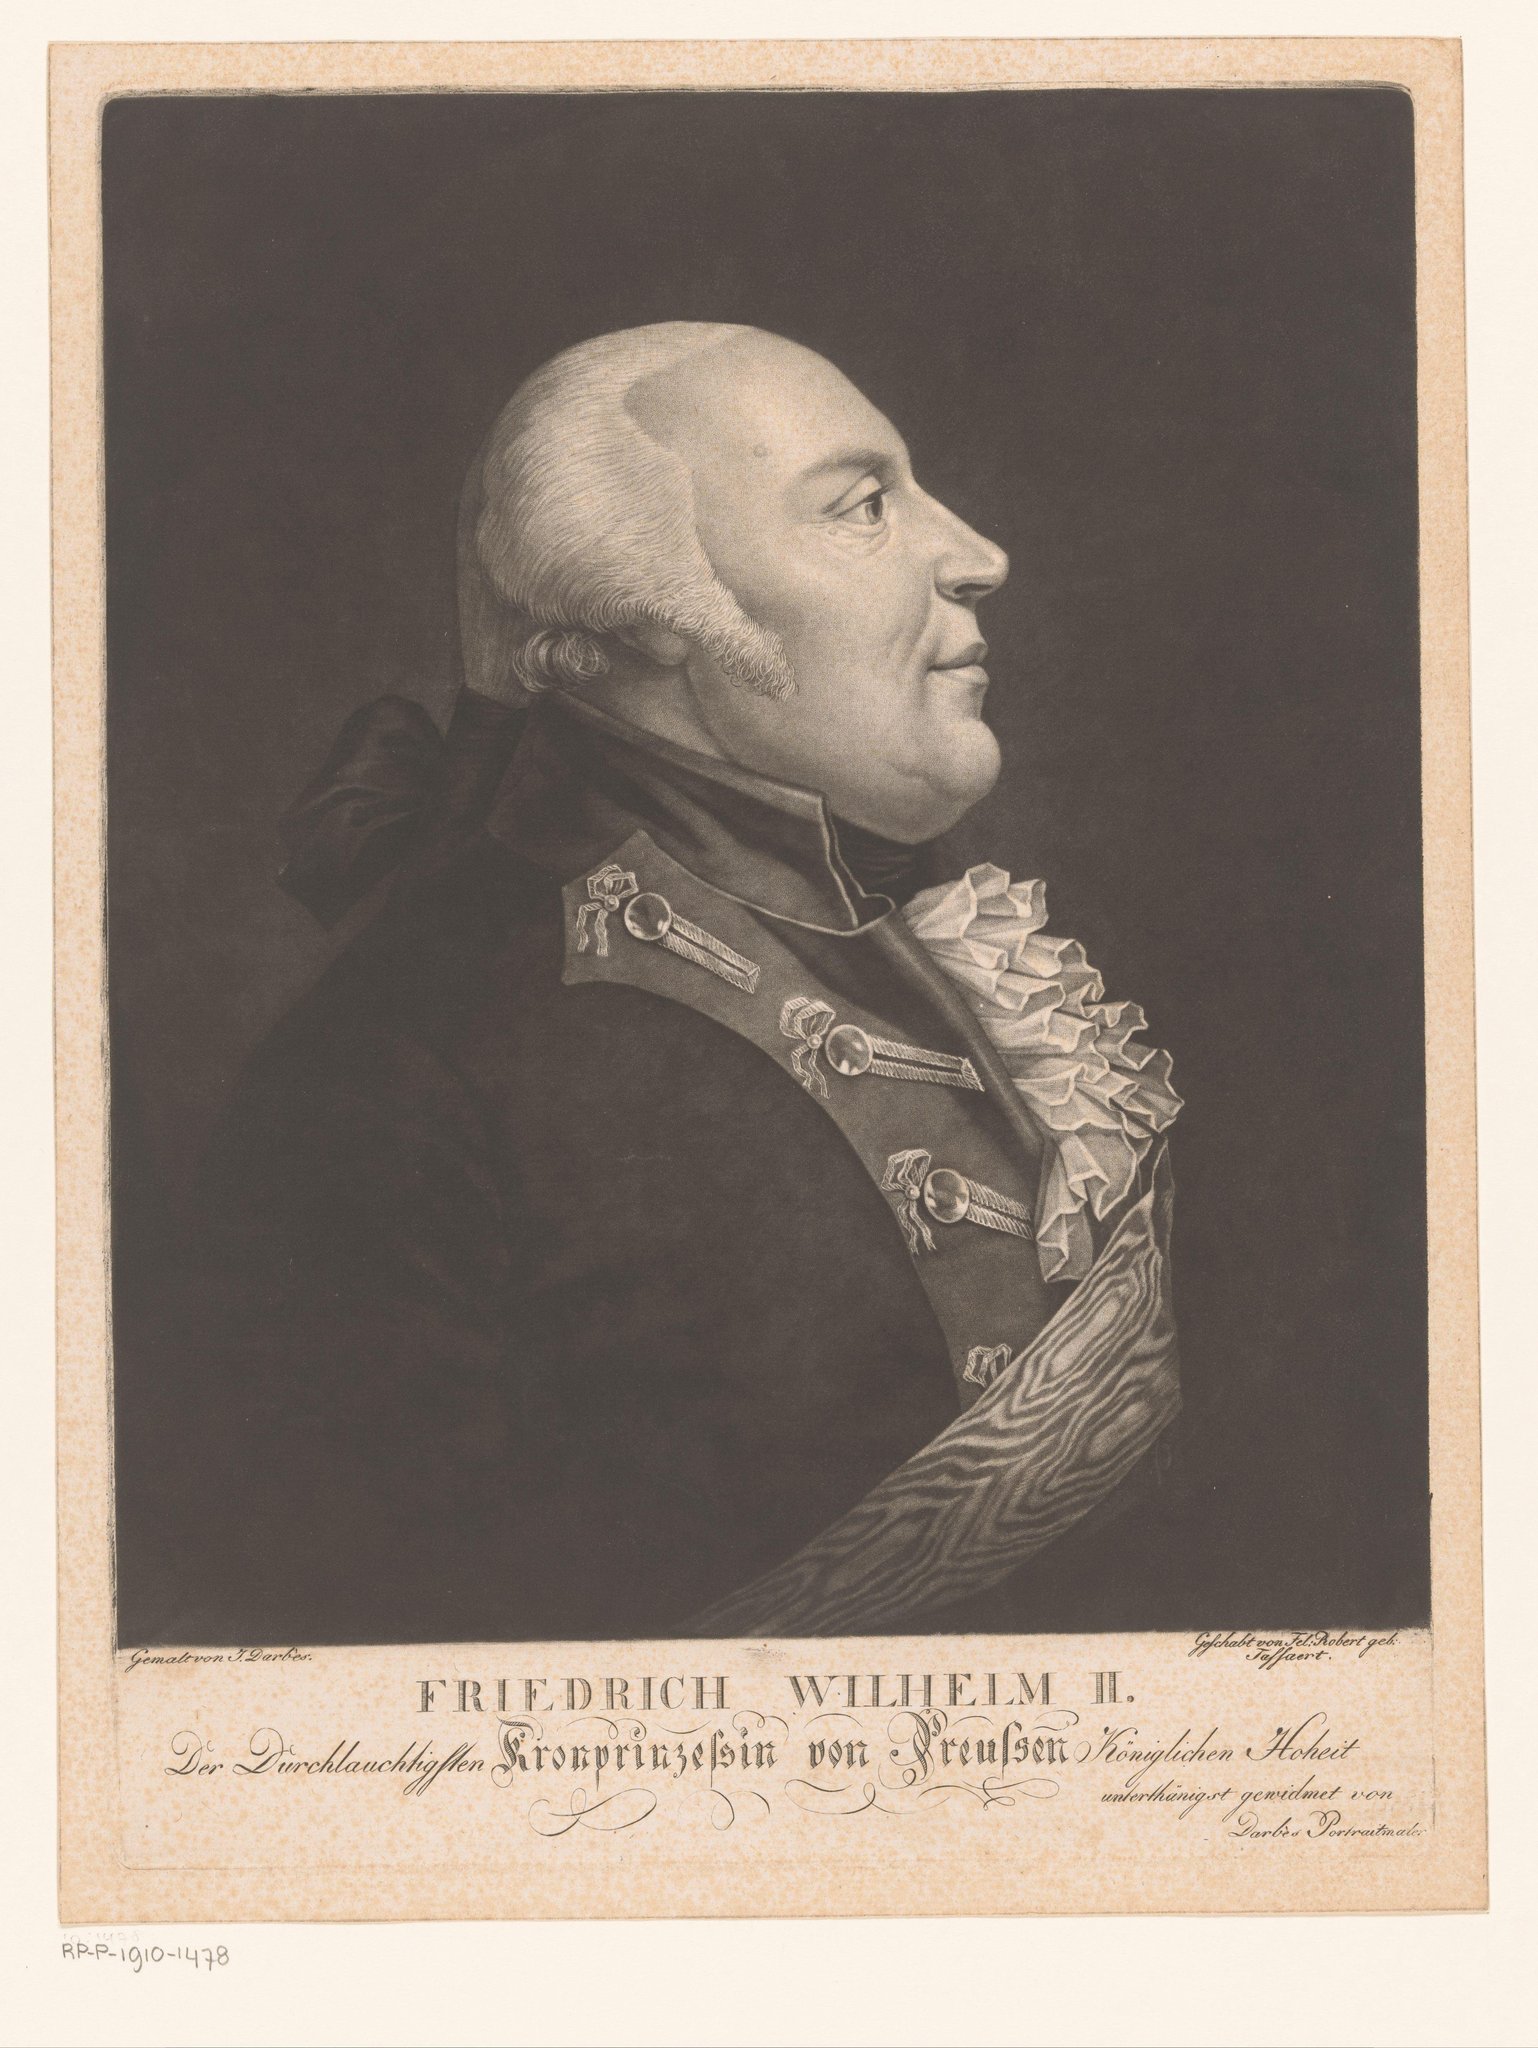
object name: print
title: Borstbeeld van Frederik Willem II van Pruisen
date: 1776-1818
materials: paper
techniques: mezzotint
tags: frederik willem ii (koning van pruisen), historical persons, crown prince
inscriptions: collector's mark: Lugt 2228